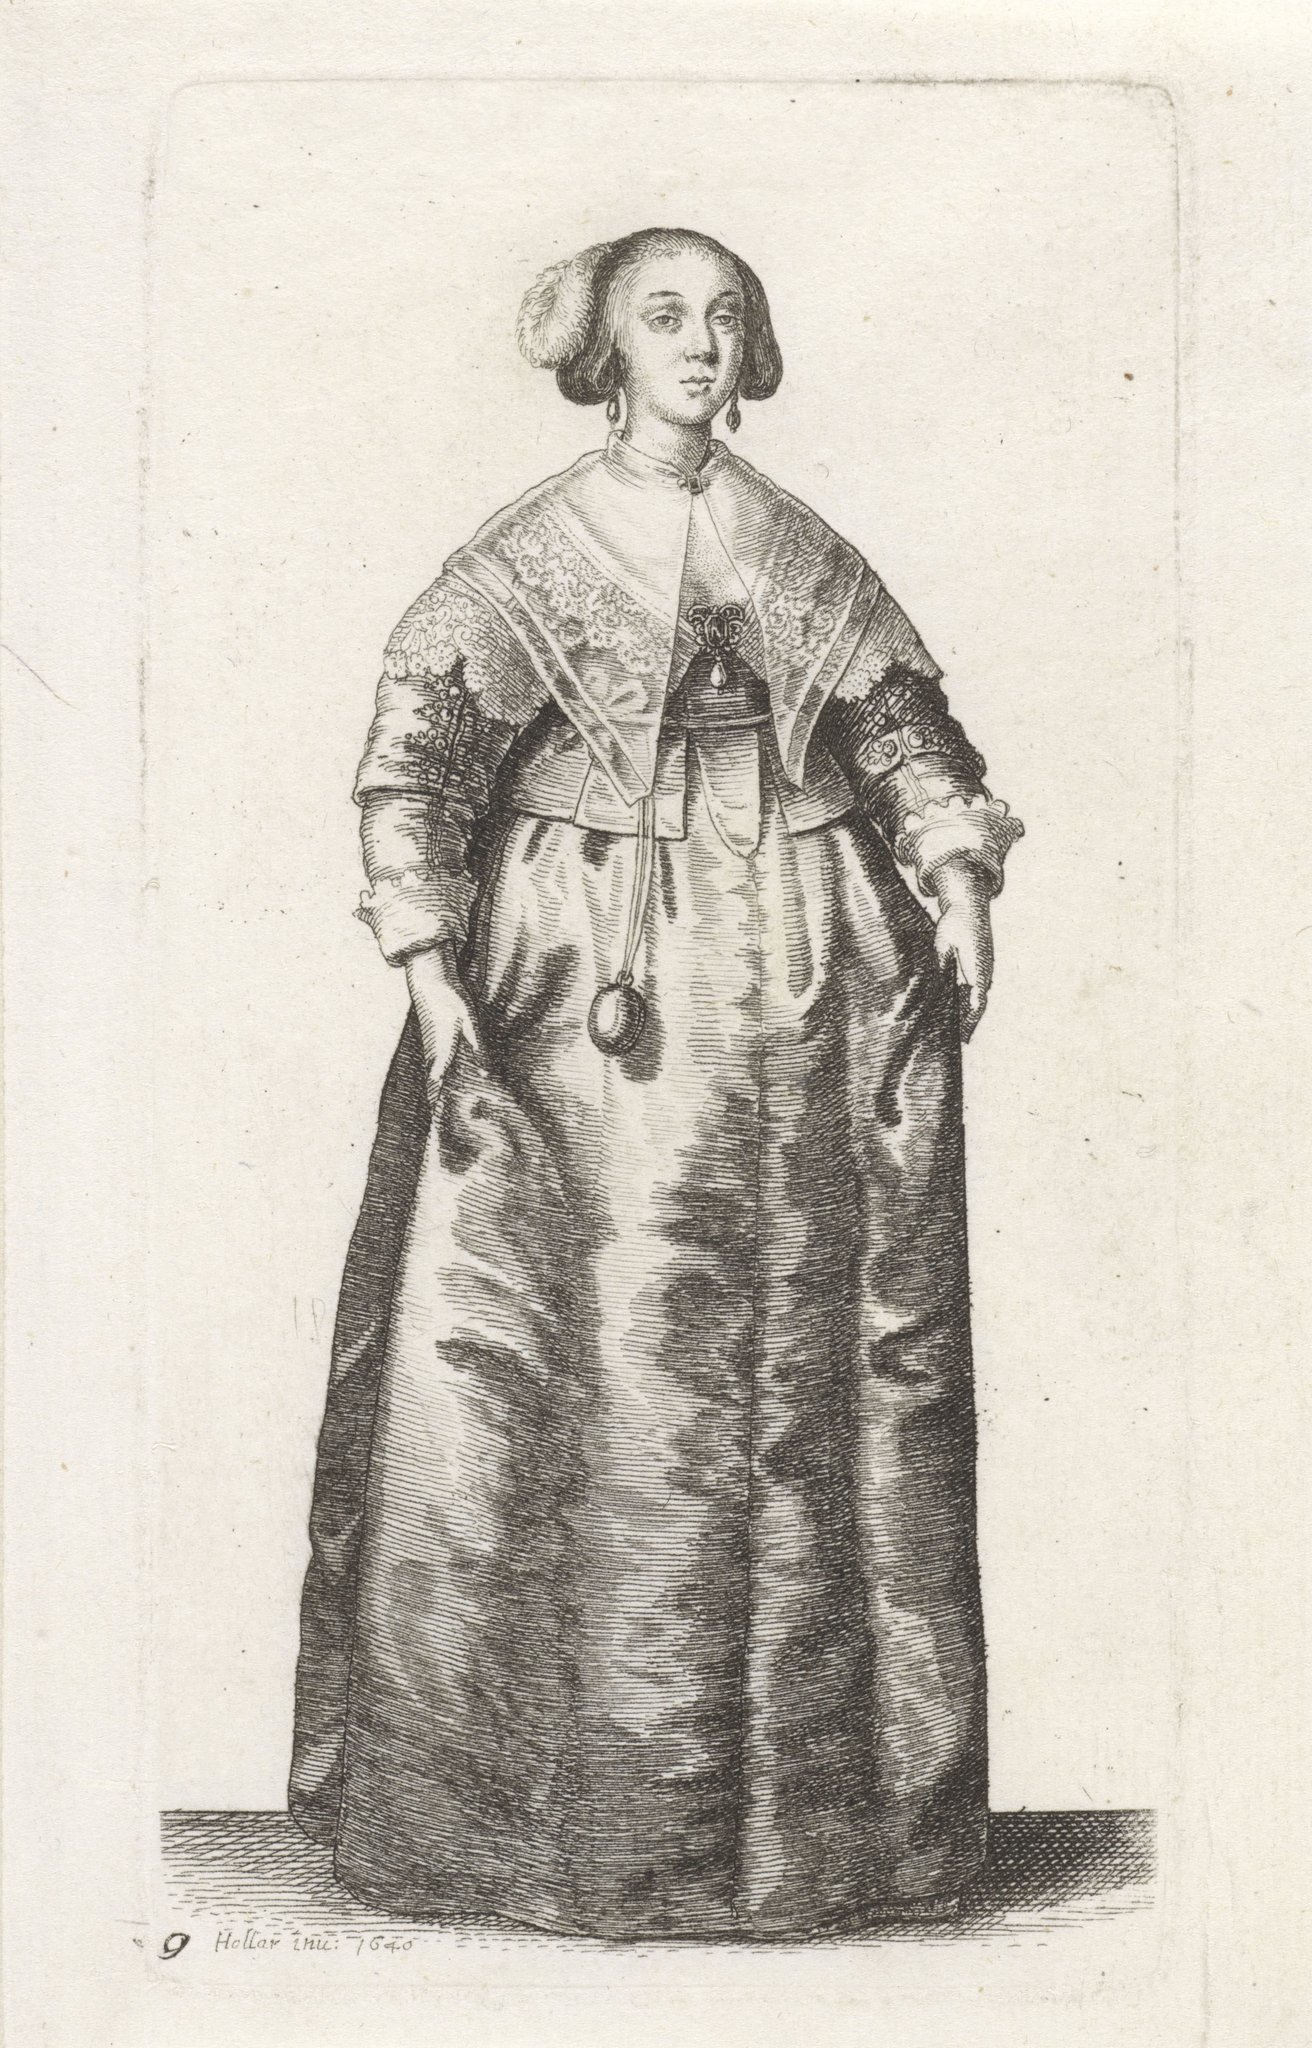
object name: costume print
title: Ornatus Muliebris Anglicanus (The Clothing of English Women)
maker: wenceslaus hollar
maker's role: draughtsman, print maker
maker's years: 1607-1677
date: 1640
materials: paper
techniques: etching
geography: london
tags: ear-rings (+ women's clothes), europeans: englishmen (+ women), styles of hairdress - aa - ~ women, head-gear: cap (+ women's clothes), clothes, costume (+ women's clothes), pomander, musk ball - aa - (for) women, piece of clothing covering the breast or décolleté (+ women's clothes), dress, gown (+ women's clothes), belt, girdle, waistband (+ women's clothes), england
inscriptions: signature and date: ‘Hollar inv. 1640’, collector's mark: Lugt 654, number: ‘9’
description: The diversity of women’s apparel in England is illustrated in this extensive costume series. Hollar represented women from all ranks of society, from the humble countrywoman 1 to the elegant noblewoman 2. The more fashionable costumes are based on eyewitness observation of the ladies at the court of the Earl of Arundel, Hollar’s primary patron. They are therefore among the more reliable visual sources for costume historians.